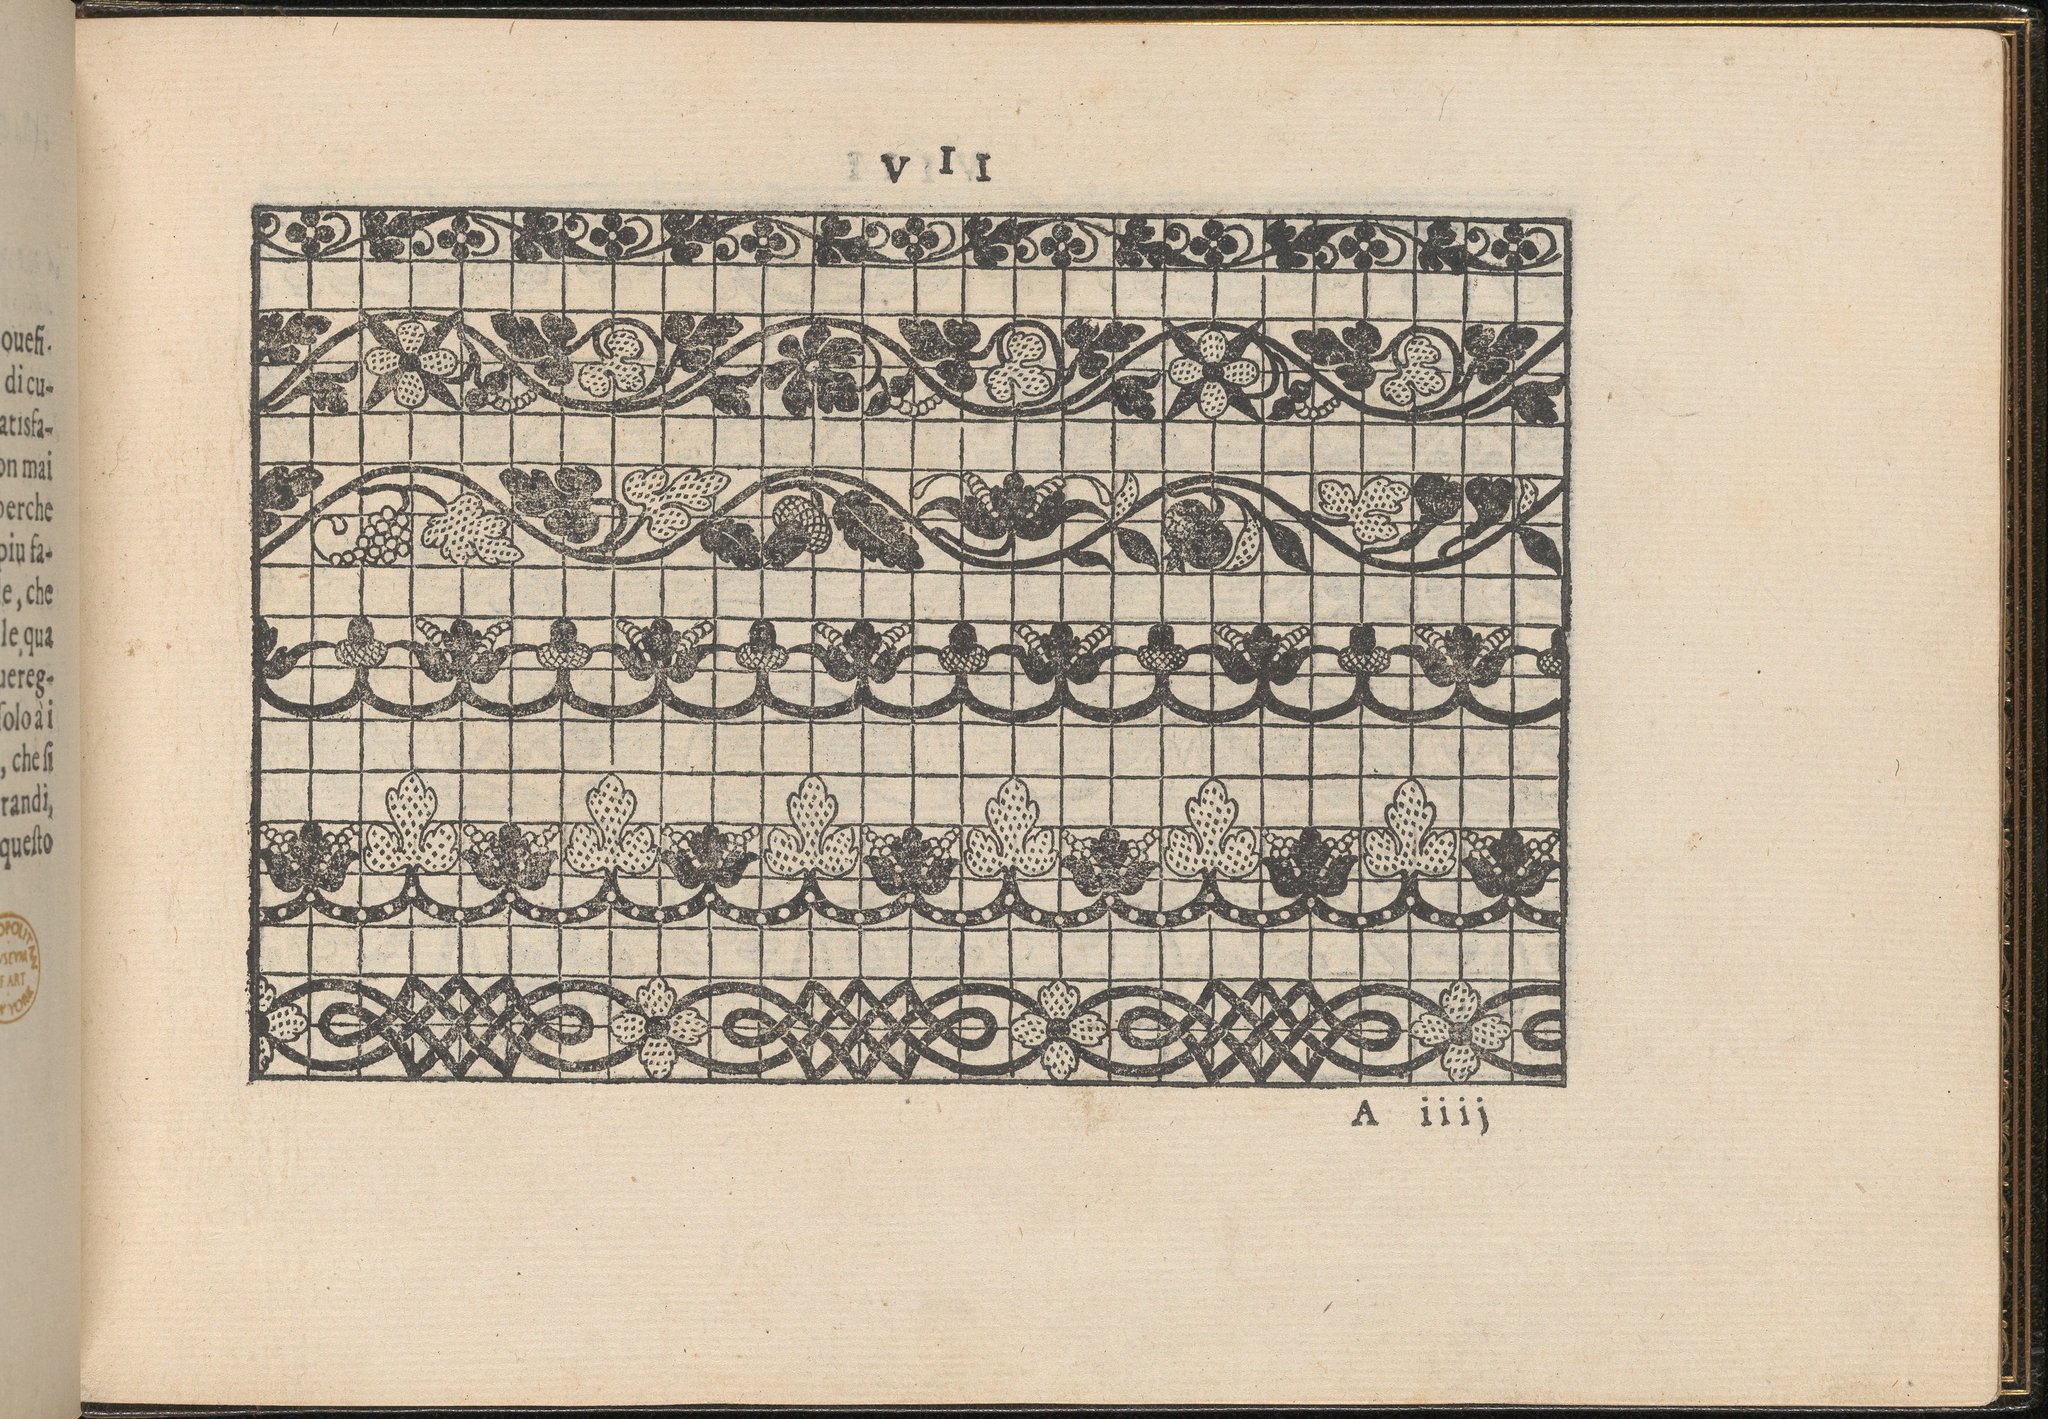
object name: book print ornament architecture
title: La Vera Perfettione del Disegno di varie sorti di recami, page 4 (recto)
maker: giovanni ostaus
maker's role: publisher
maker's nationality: italian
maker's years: 1507-1607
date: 1567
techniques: woodcut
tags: flowers